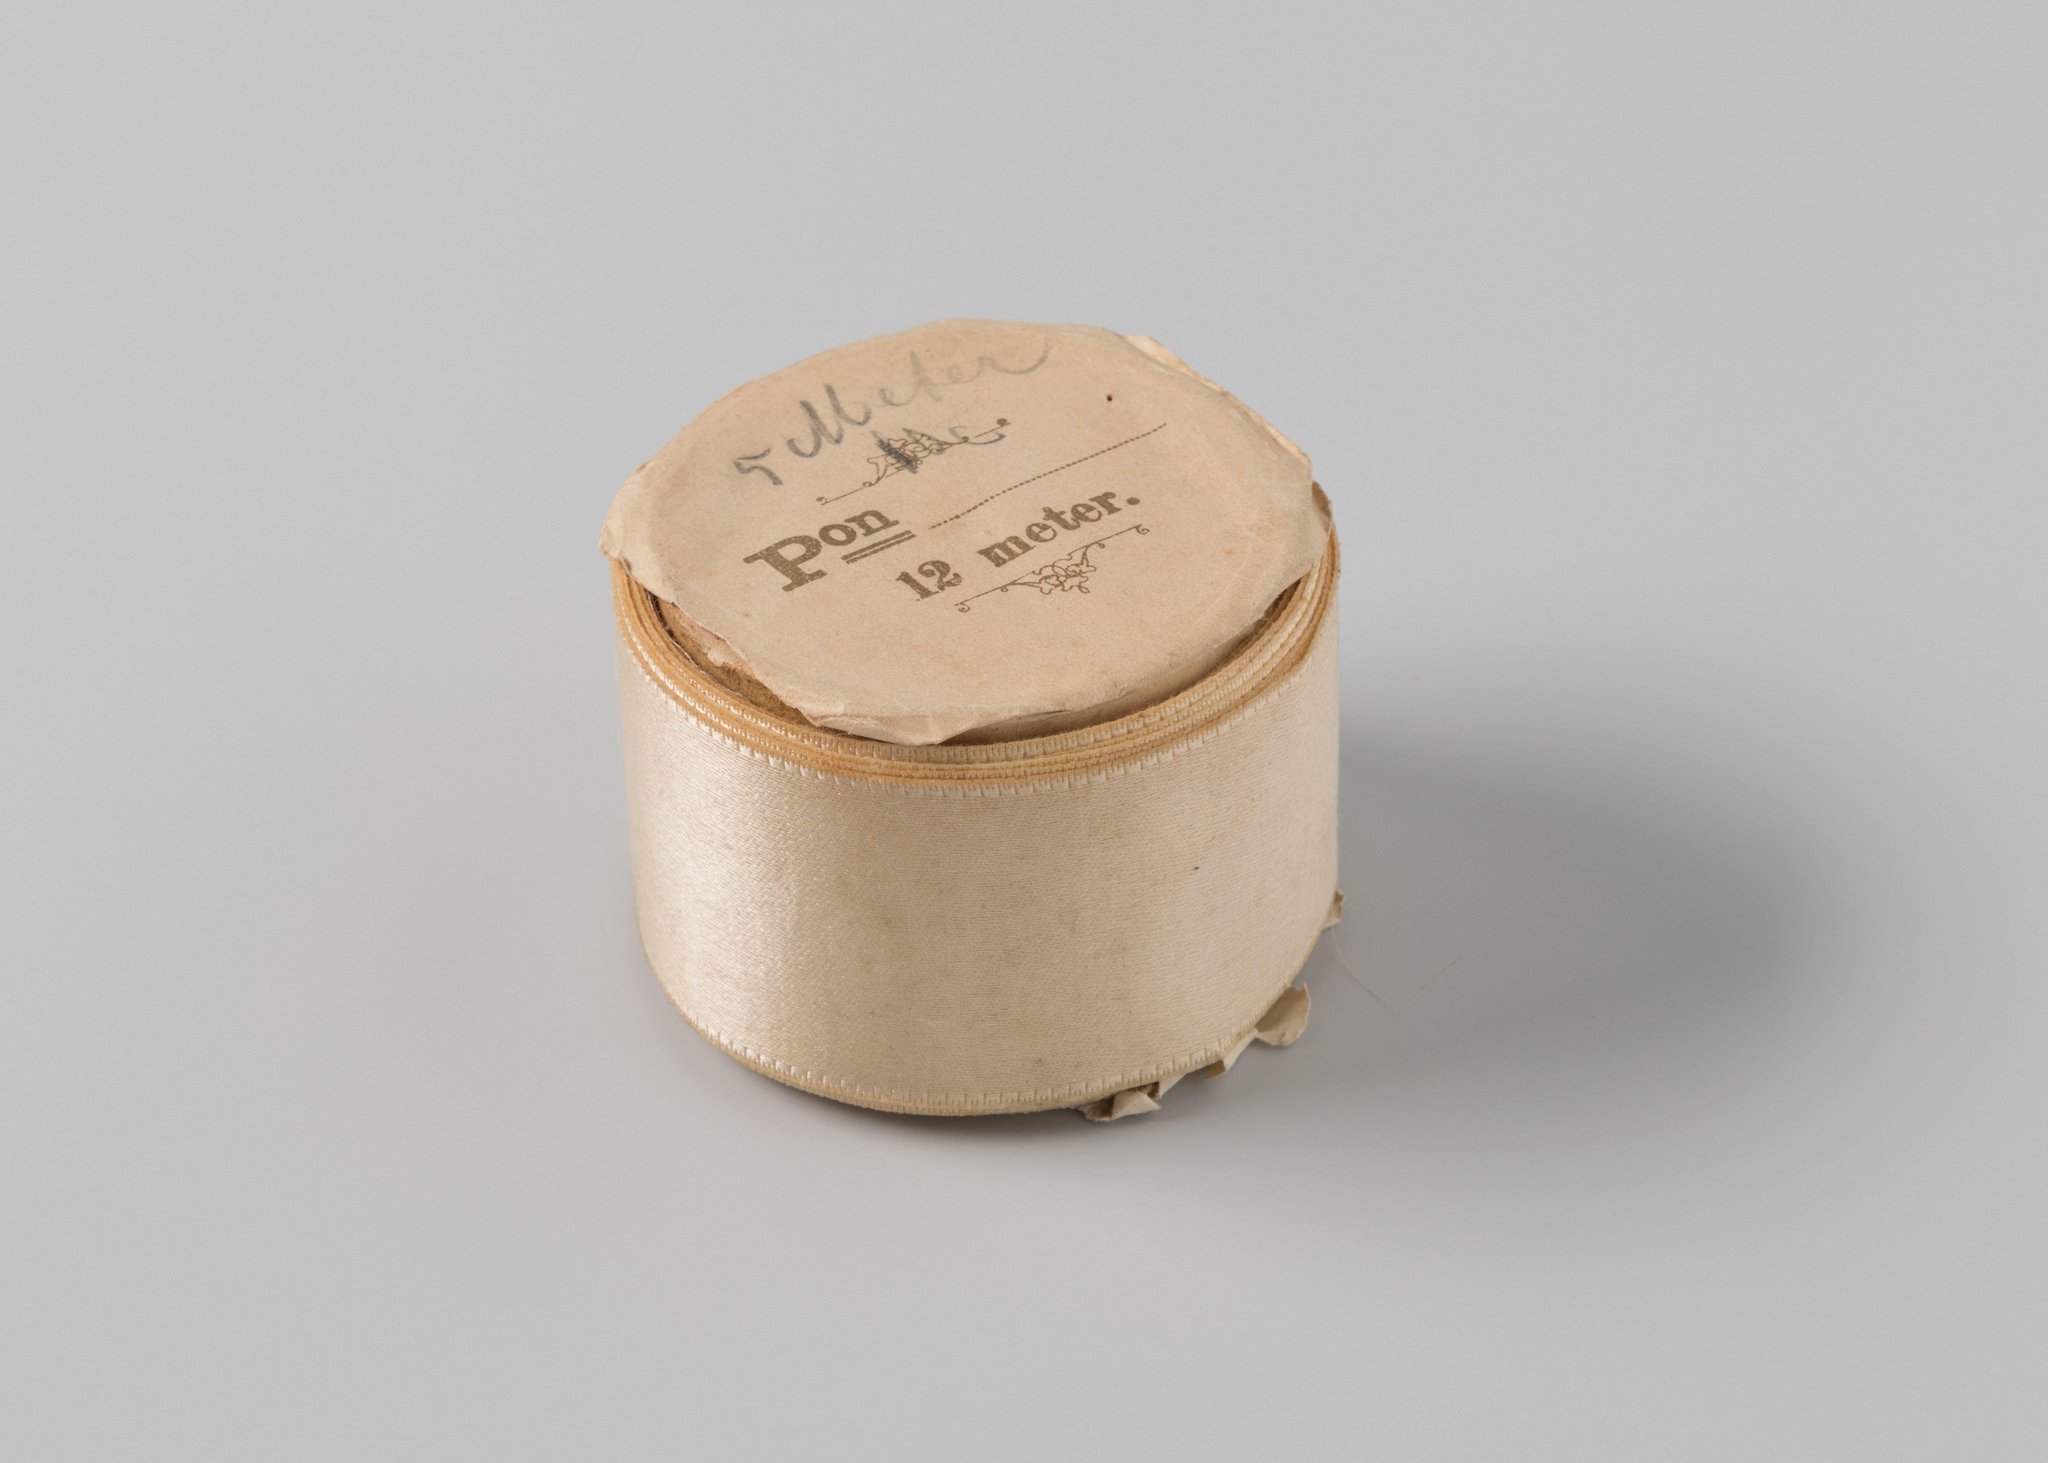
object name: braid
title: Rol met crème zijden satijnlint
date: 1925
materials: silk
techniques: satin binding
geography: france